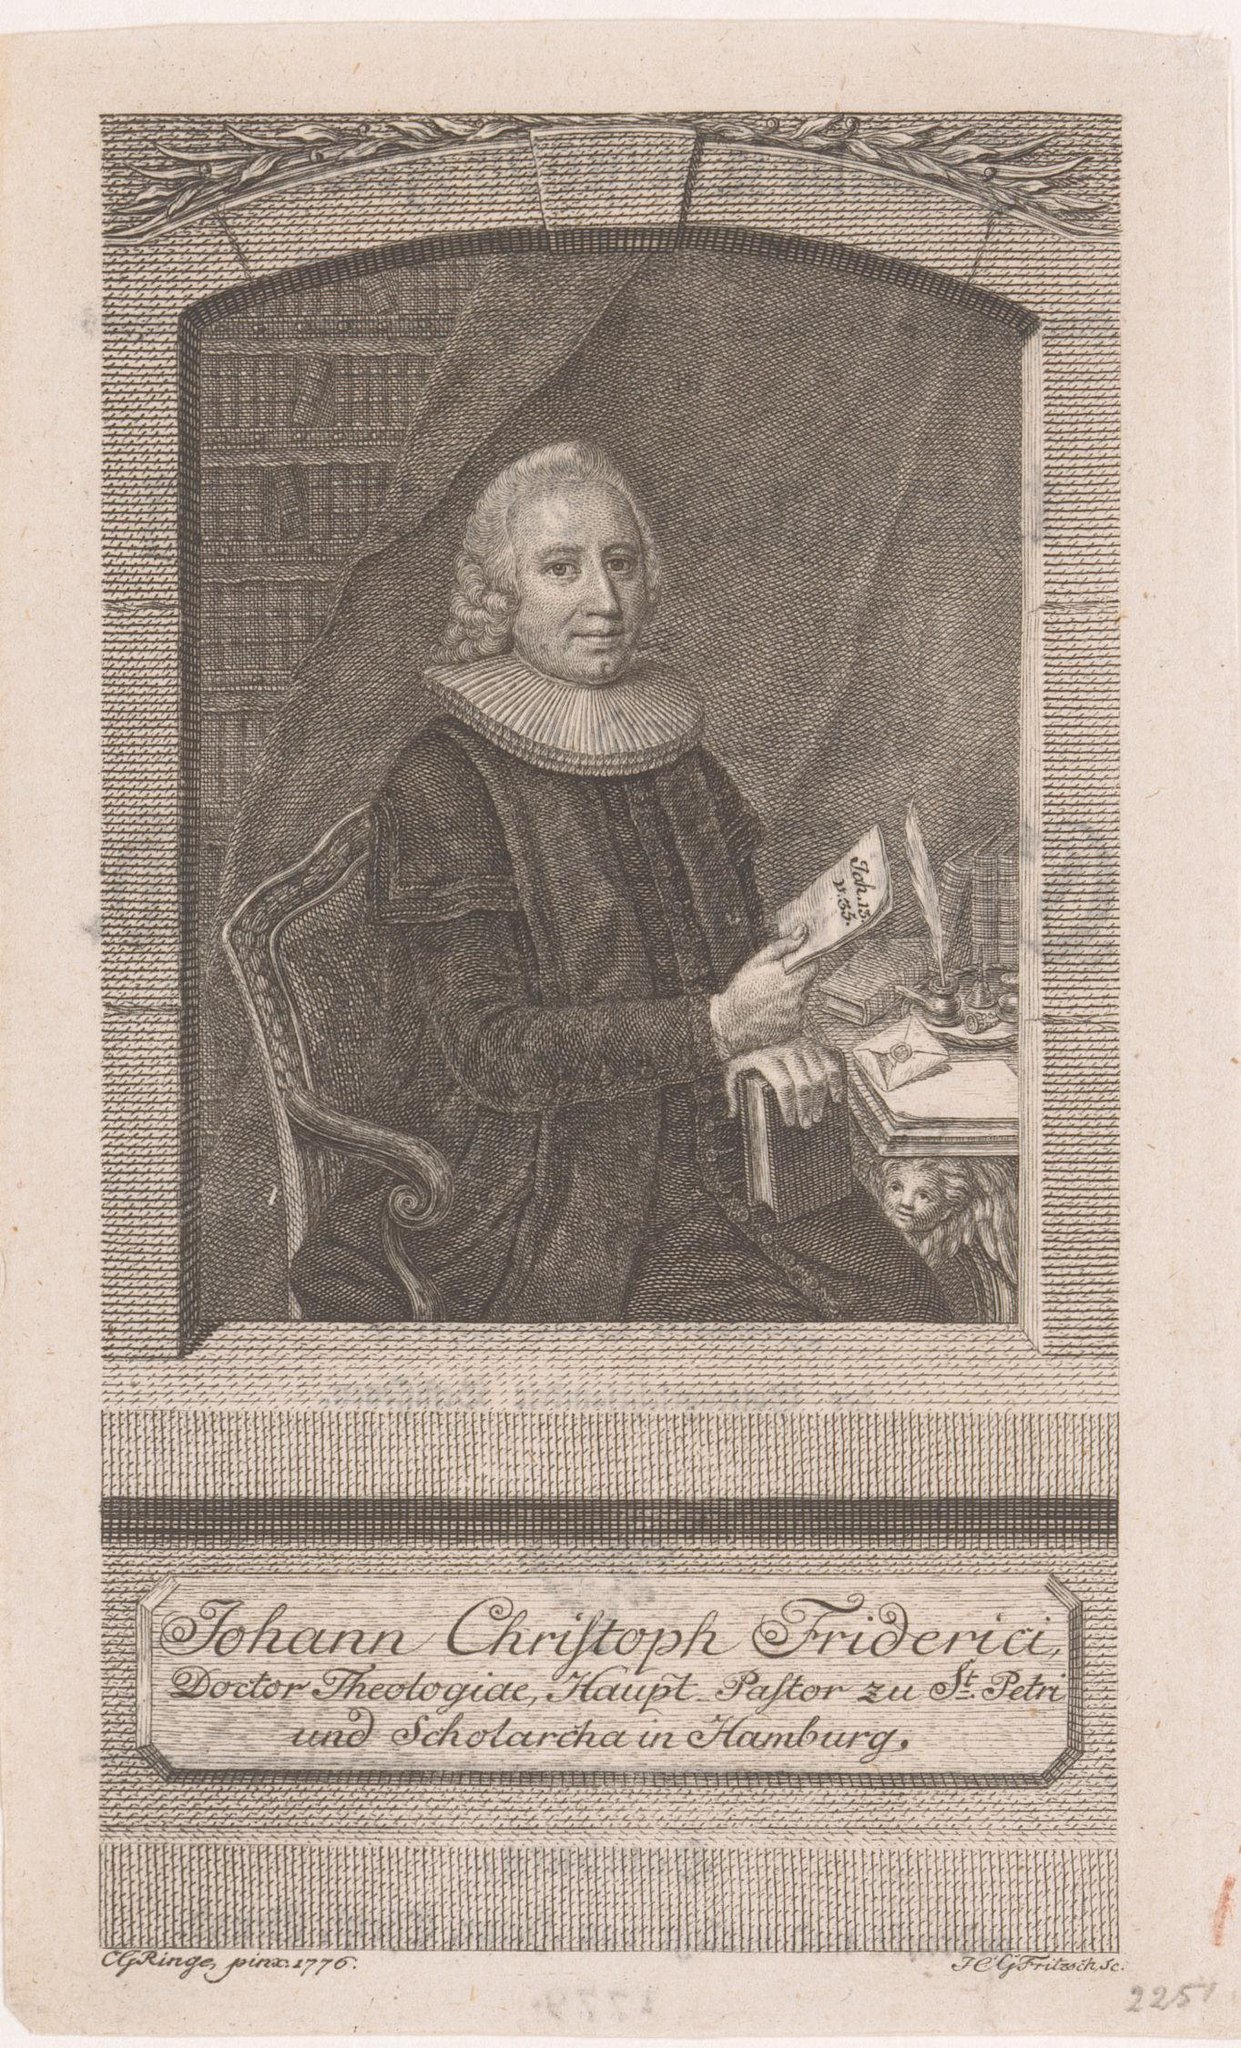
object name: print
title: Portret van Johann Christoph Friderici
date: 1776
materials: paper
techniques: engraving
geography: hamburg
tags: bookshelves, theologian, writing tools, historical persons, ornament ~ festoon, garland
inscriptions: collector's mark: Lugt 2228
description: Prent uit: Friderici, Johann Christoph. Theologische Abhandlung von der wahren und eigentlich Christlichen Tugend. Hamburg: Heinrich Christian Grund, 1779.